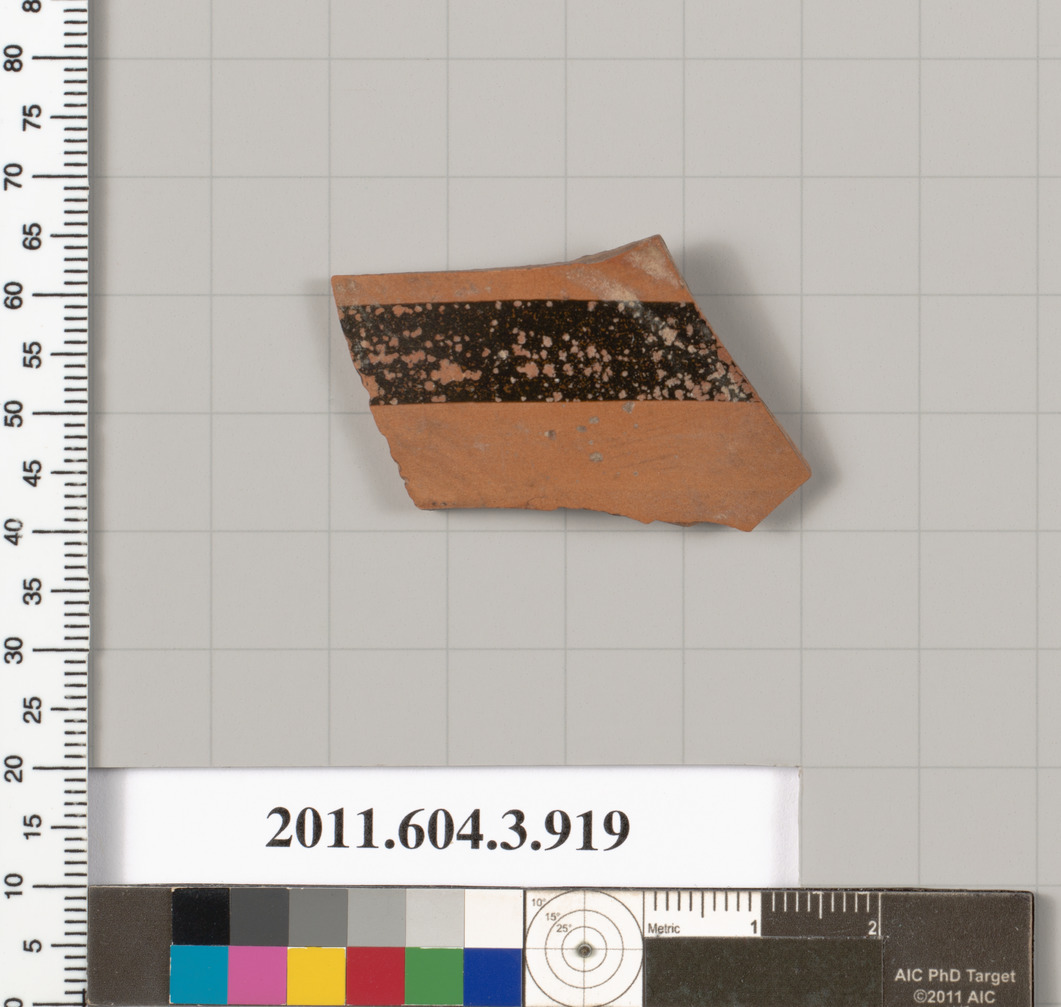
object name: lekythos fragment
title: Terracotta fragment of a lekythos (oil flask)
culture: greek, attic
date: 600-401 BCE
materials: terracotta